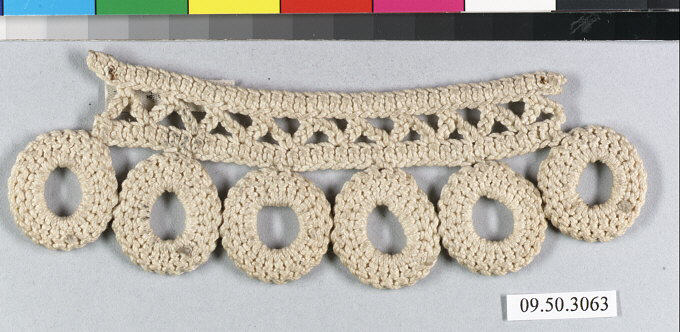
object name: sample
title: Crochet Work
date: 1801-1900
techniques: crochet